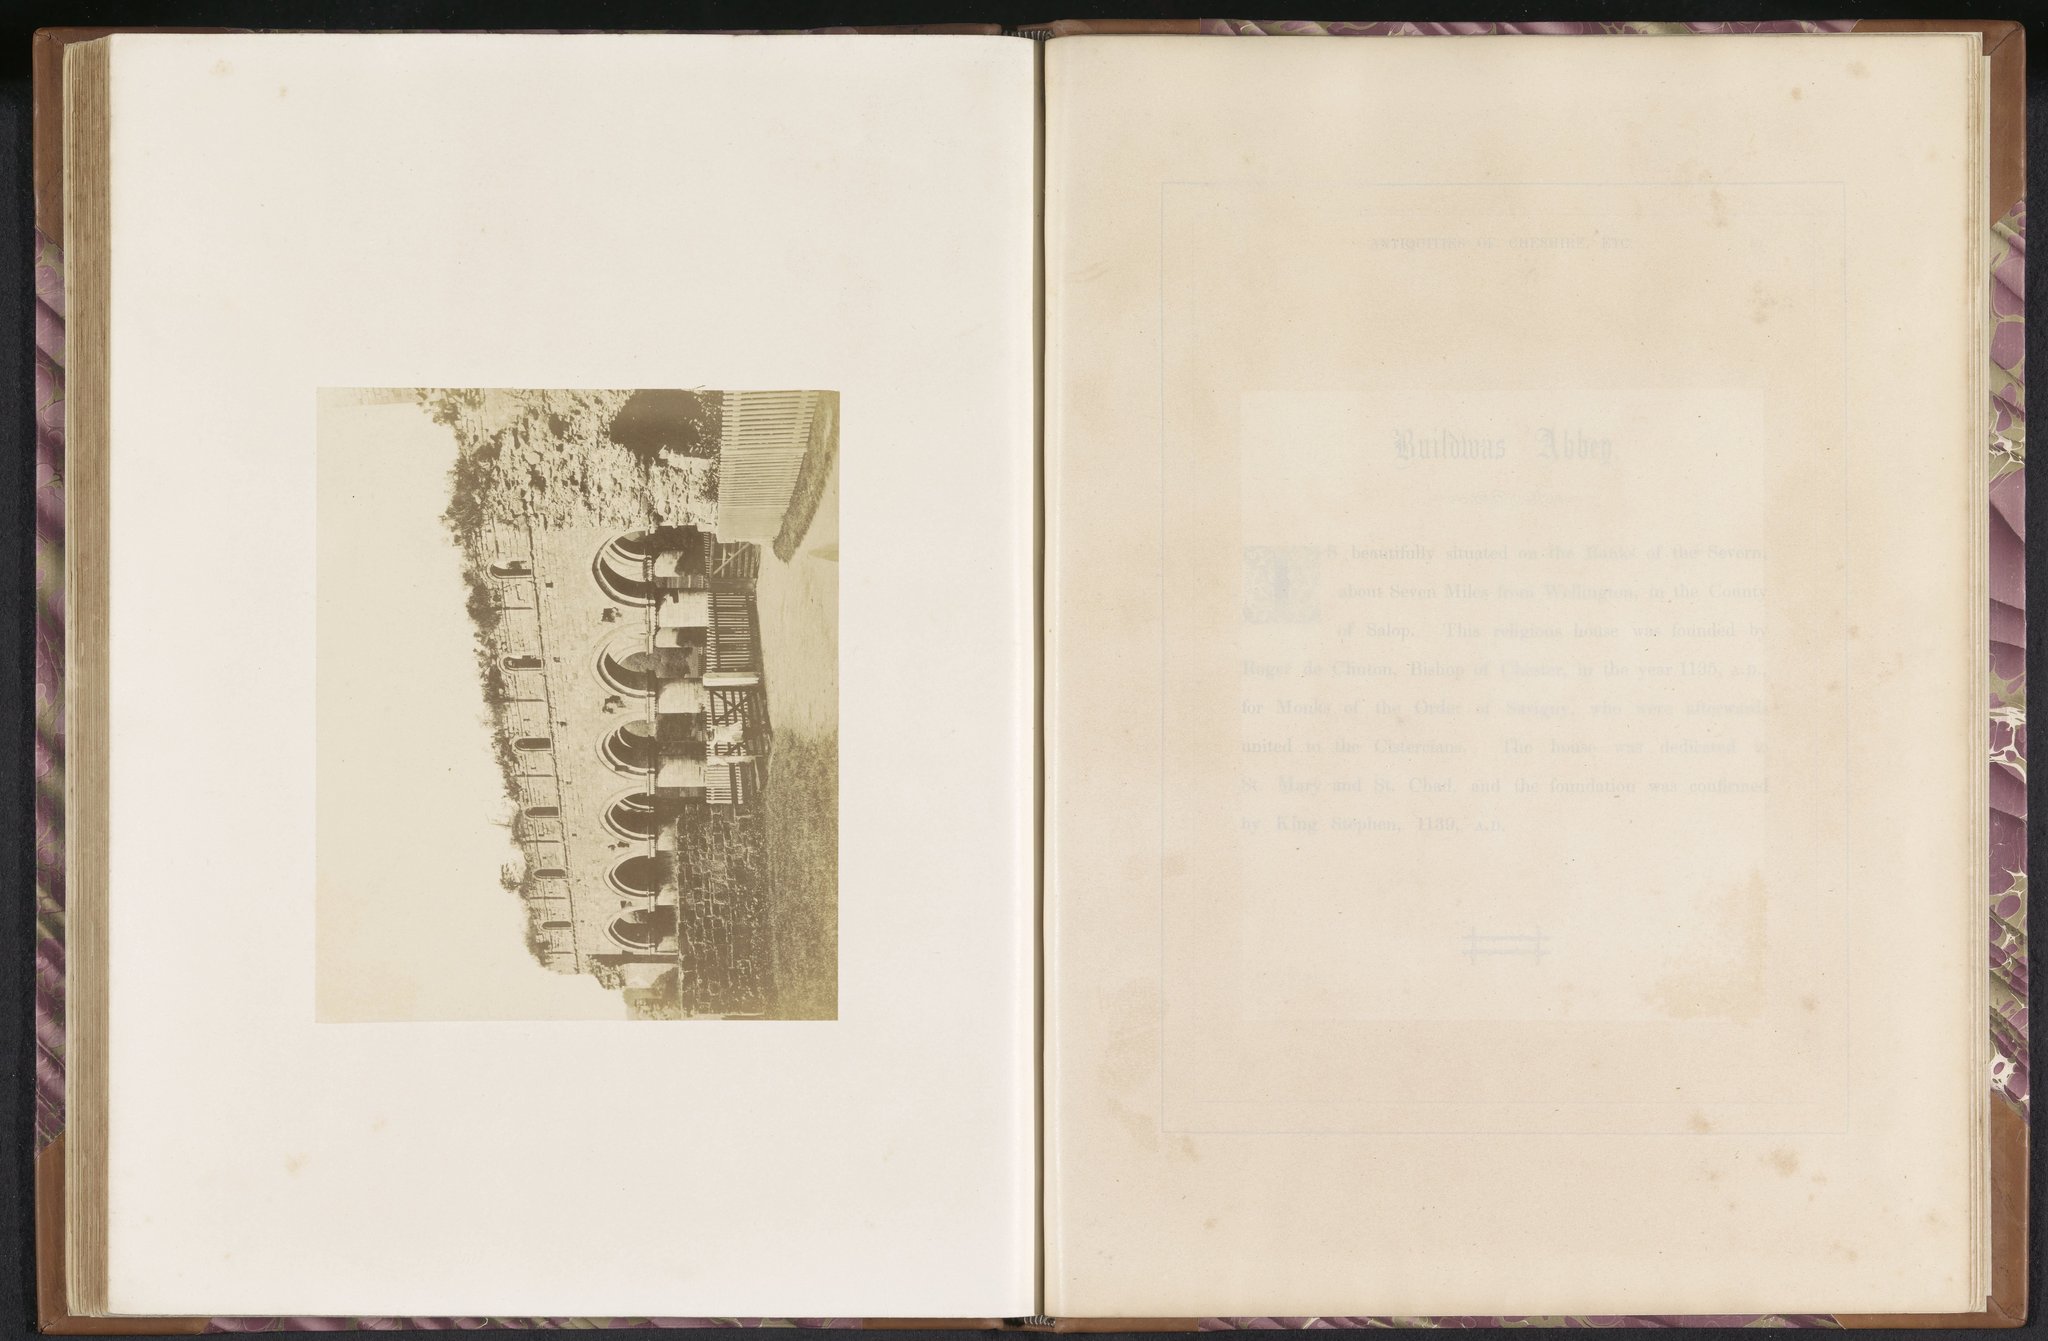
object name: photograph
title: Buildwas Abbey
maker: william bryans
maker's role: fotograaf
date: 1850-1858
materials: photographic support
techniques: albumen print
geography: buildwas abbey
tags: abbey, monastery, convent ~ roman catholic church, gate, entrance, ruin of church, monastery, etc.